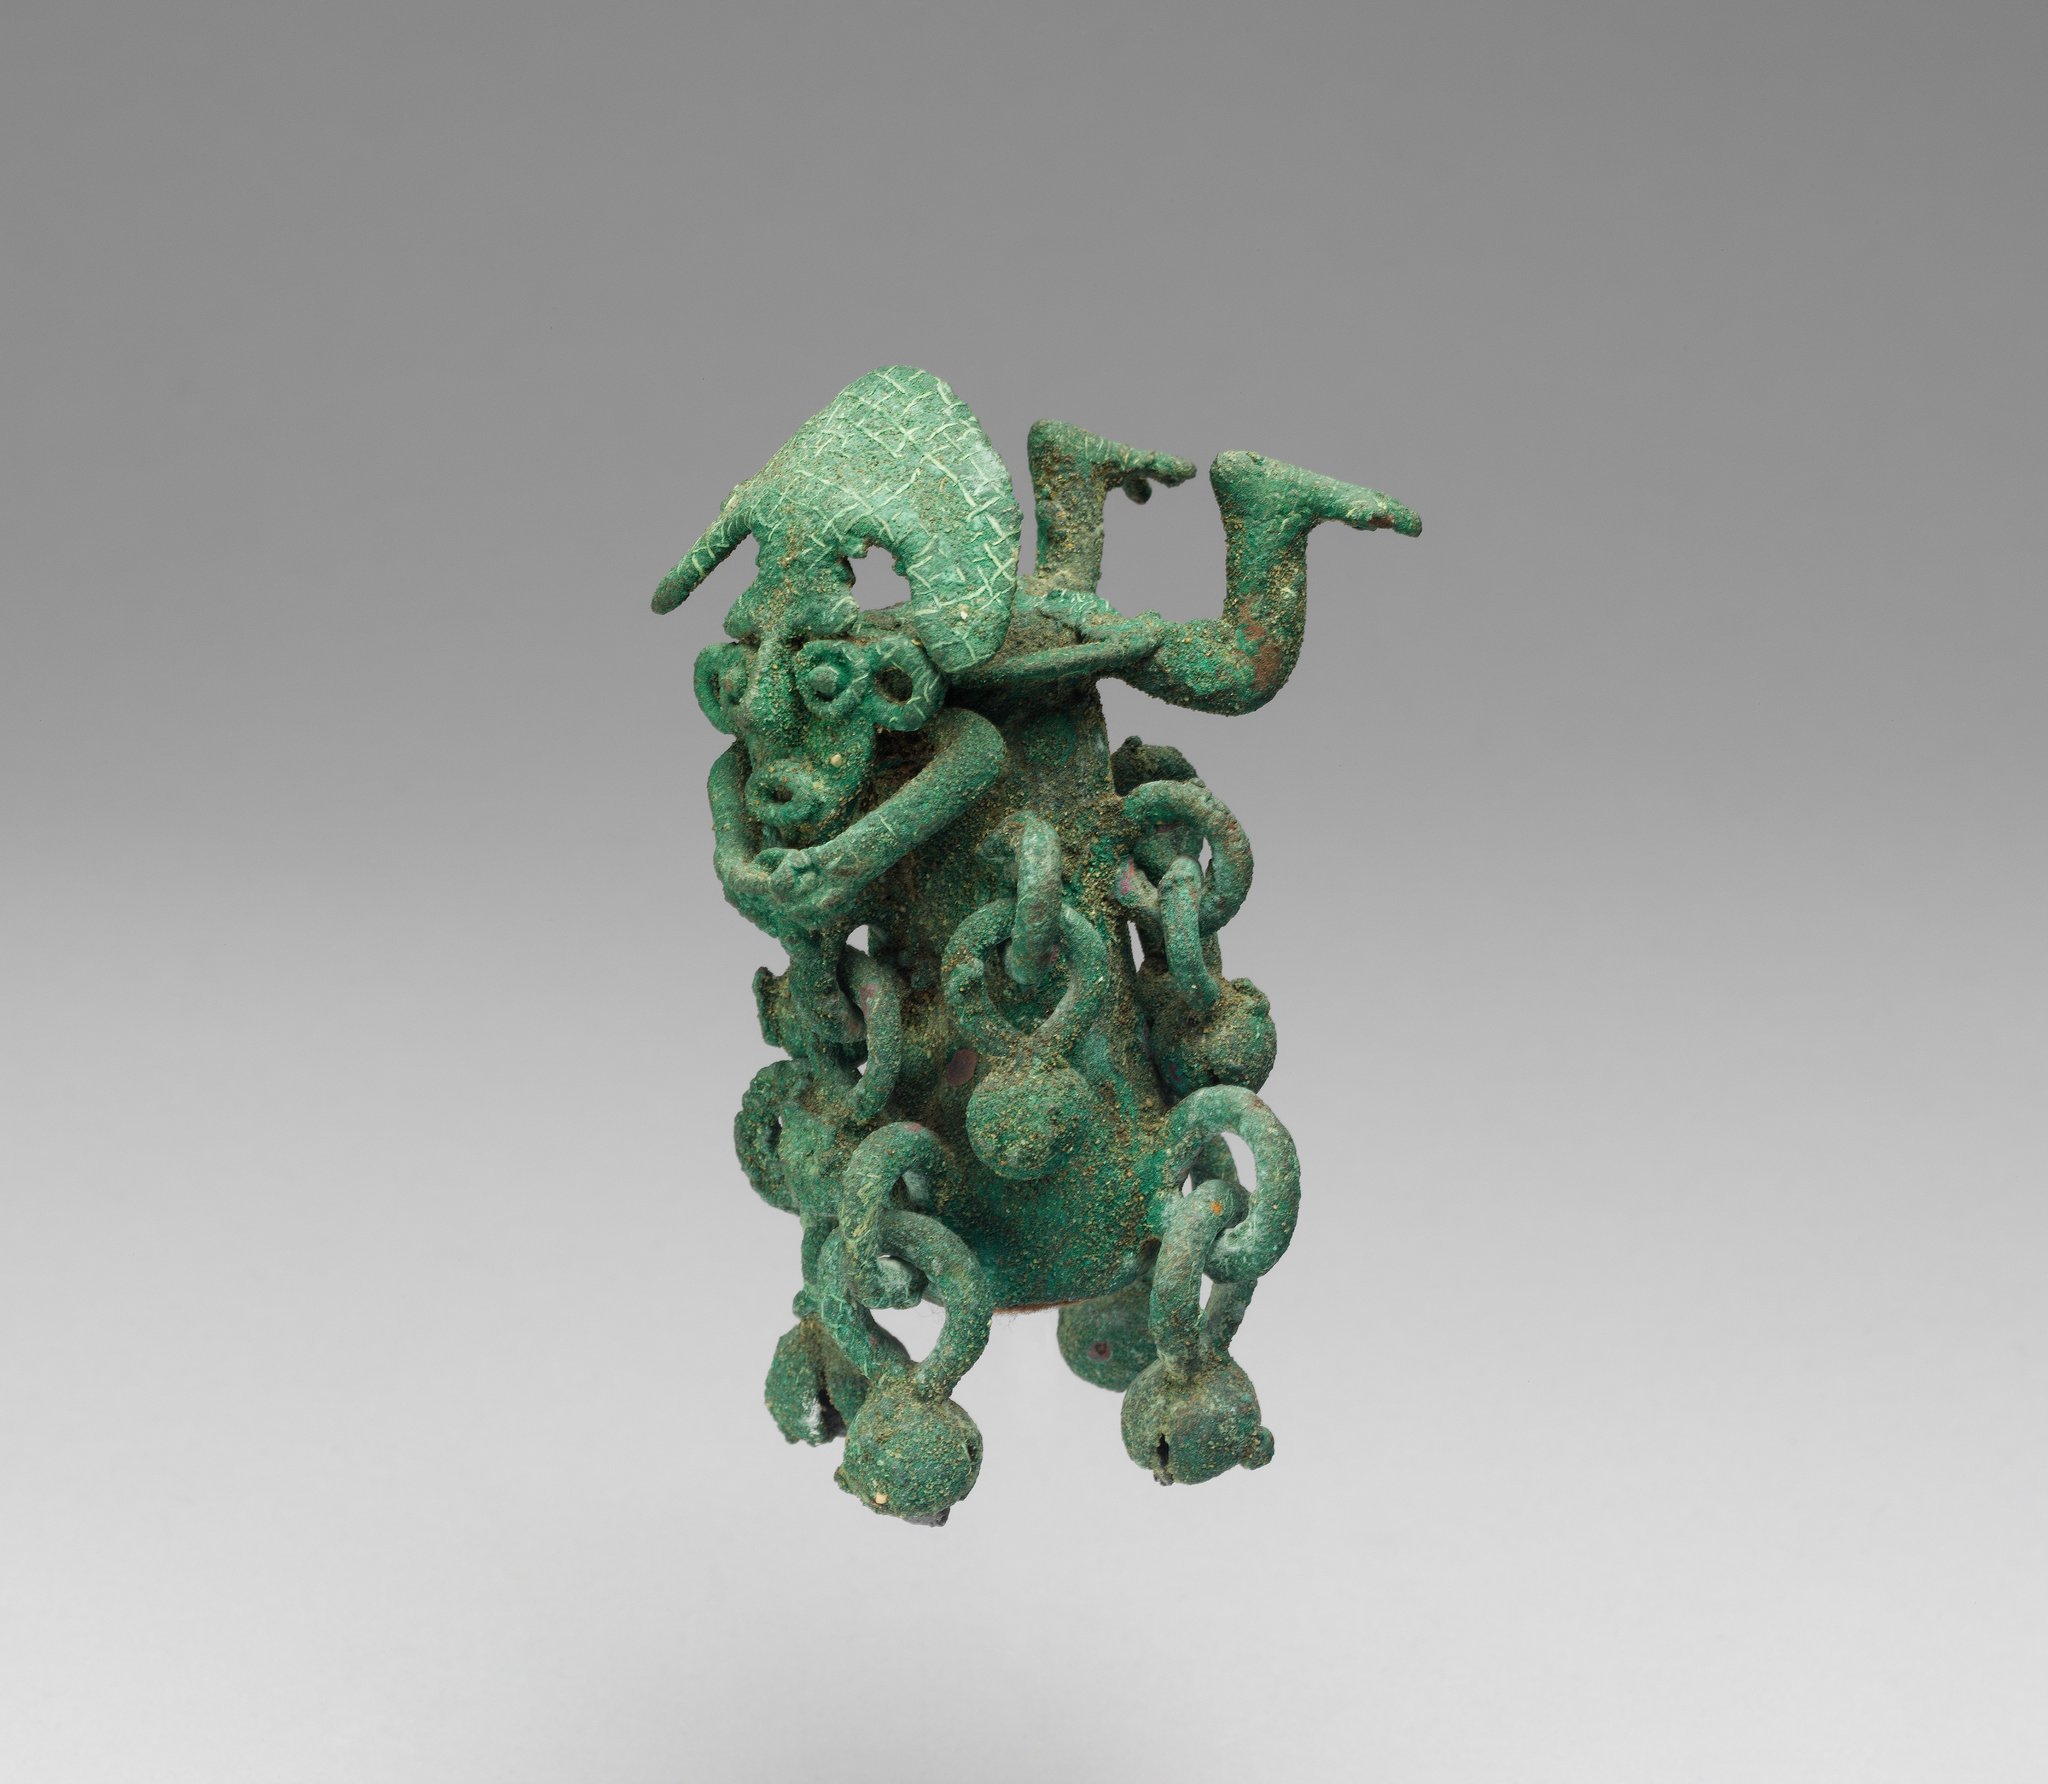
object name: finial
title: Figure Finial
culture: chimú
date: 1101-1500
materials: copper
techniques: casting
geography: peru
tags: animals